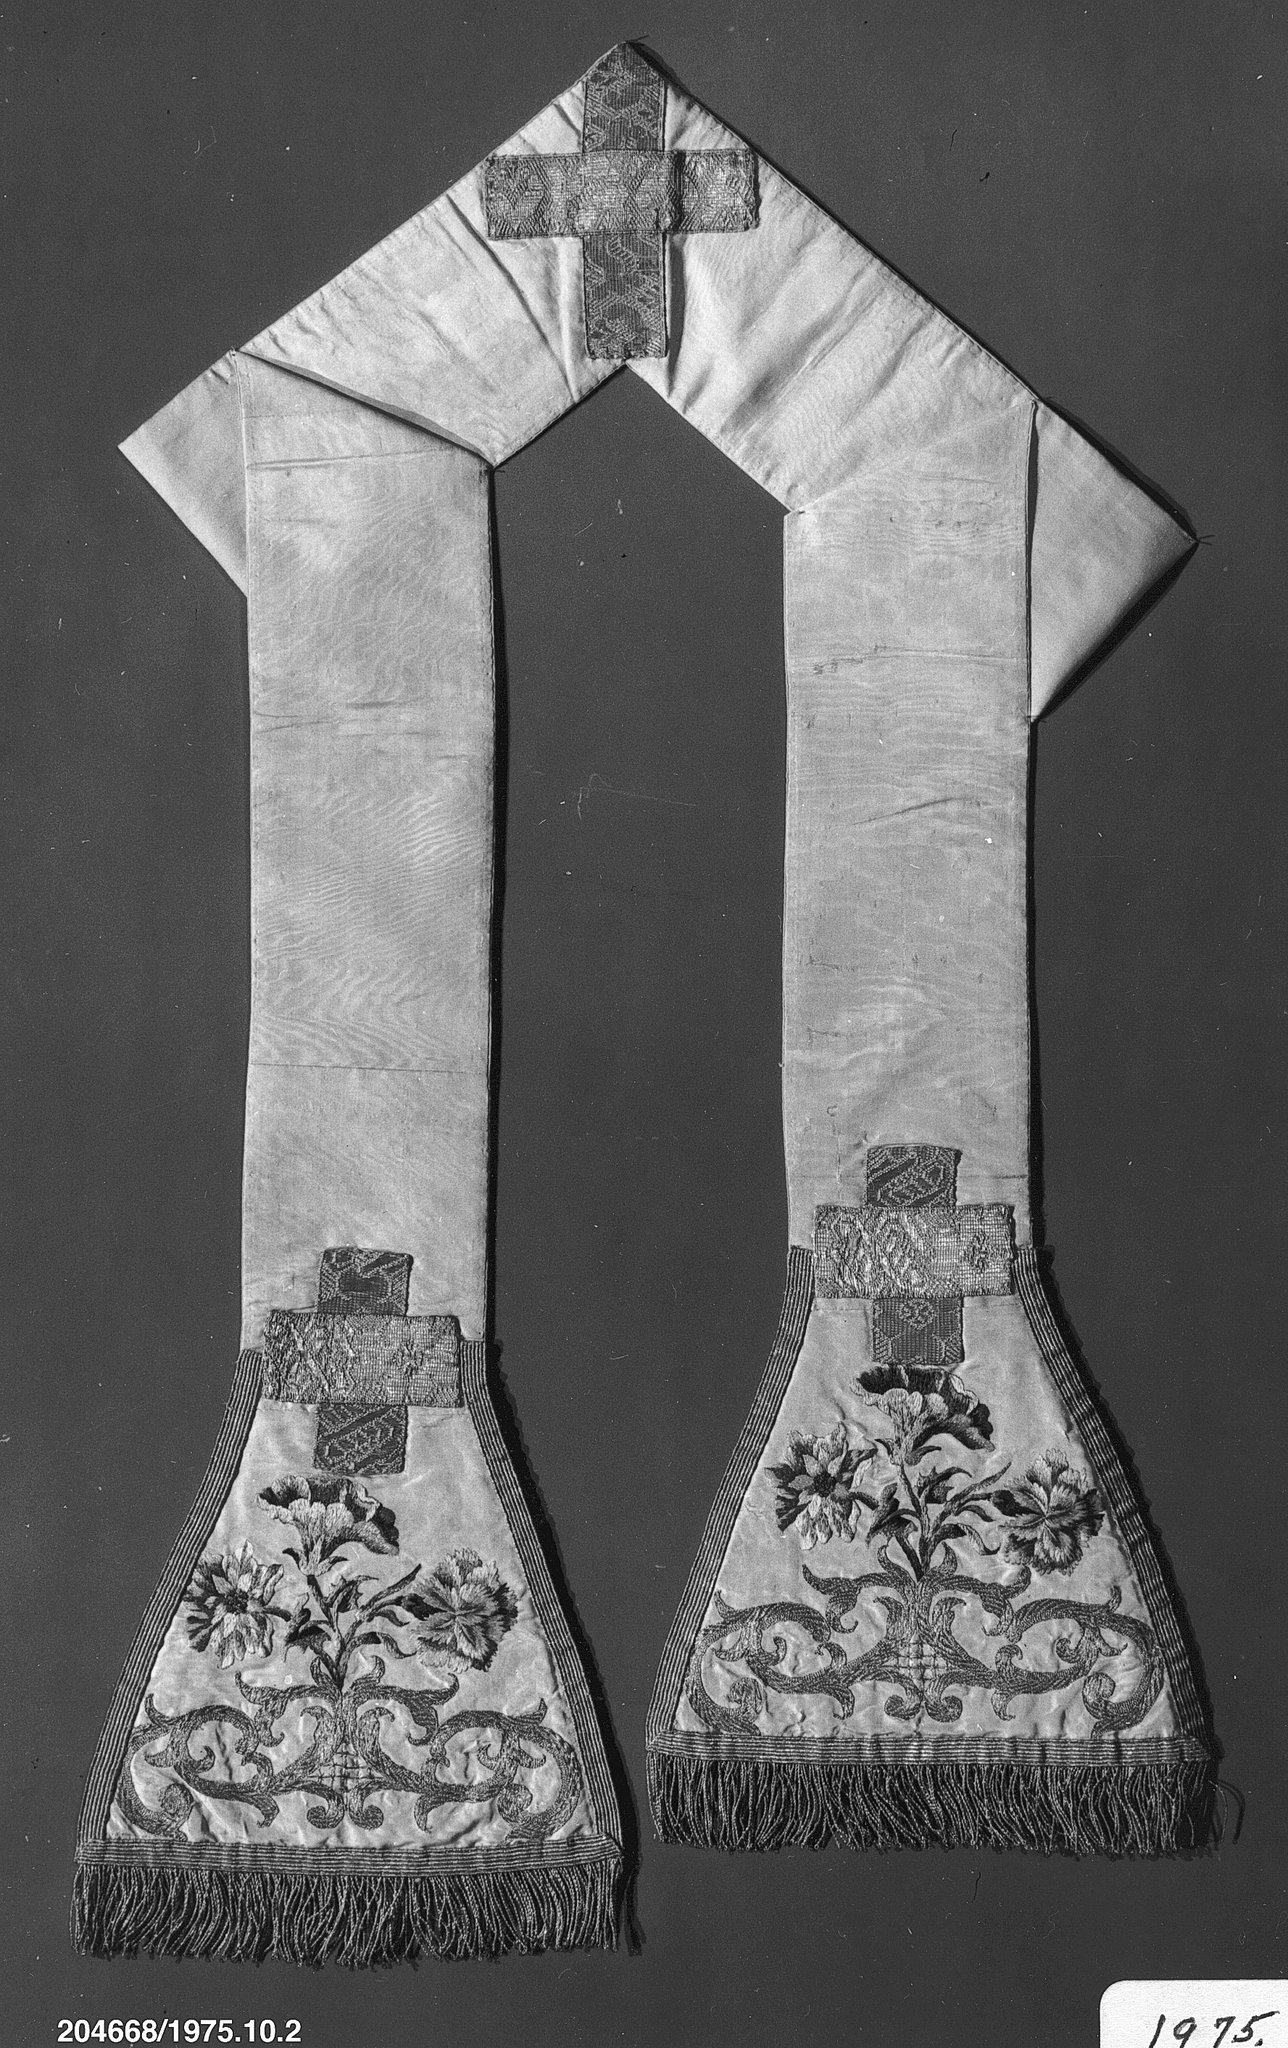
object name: stole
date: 1734-1766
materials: metal thread, silk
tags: flowers,cross